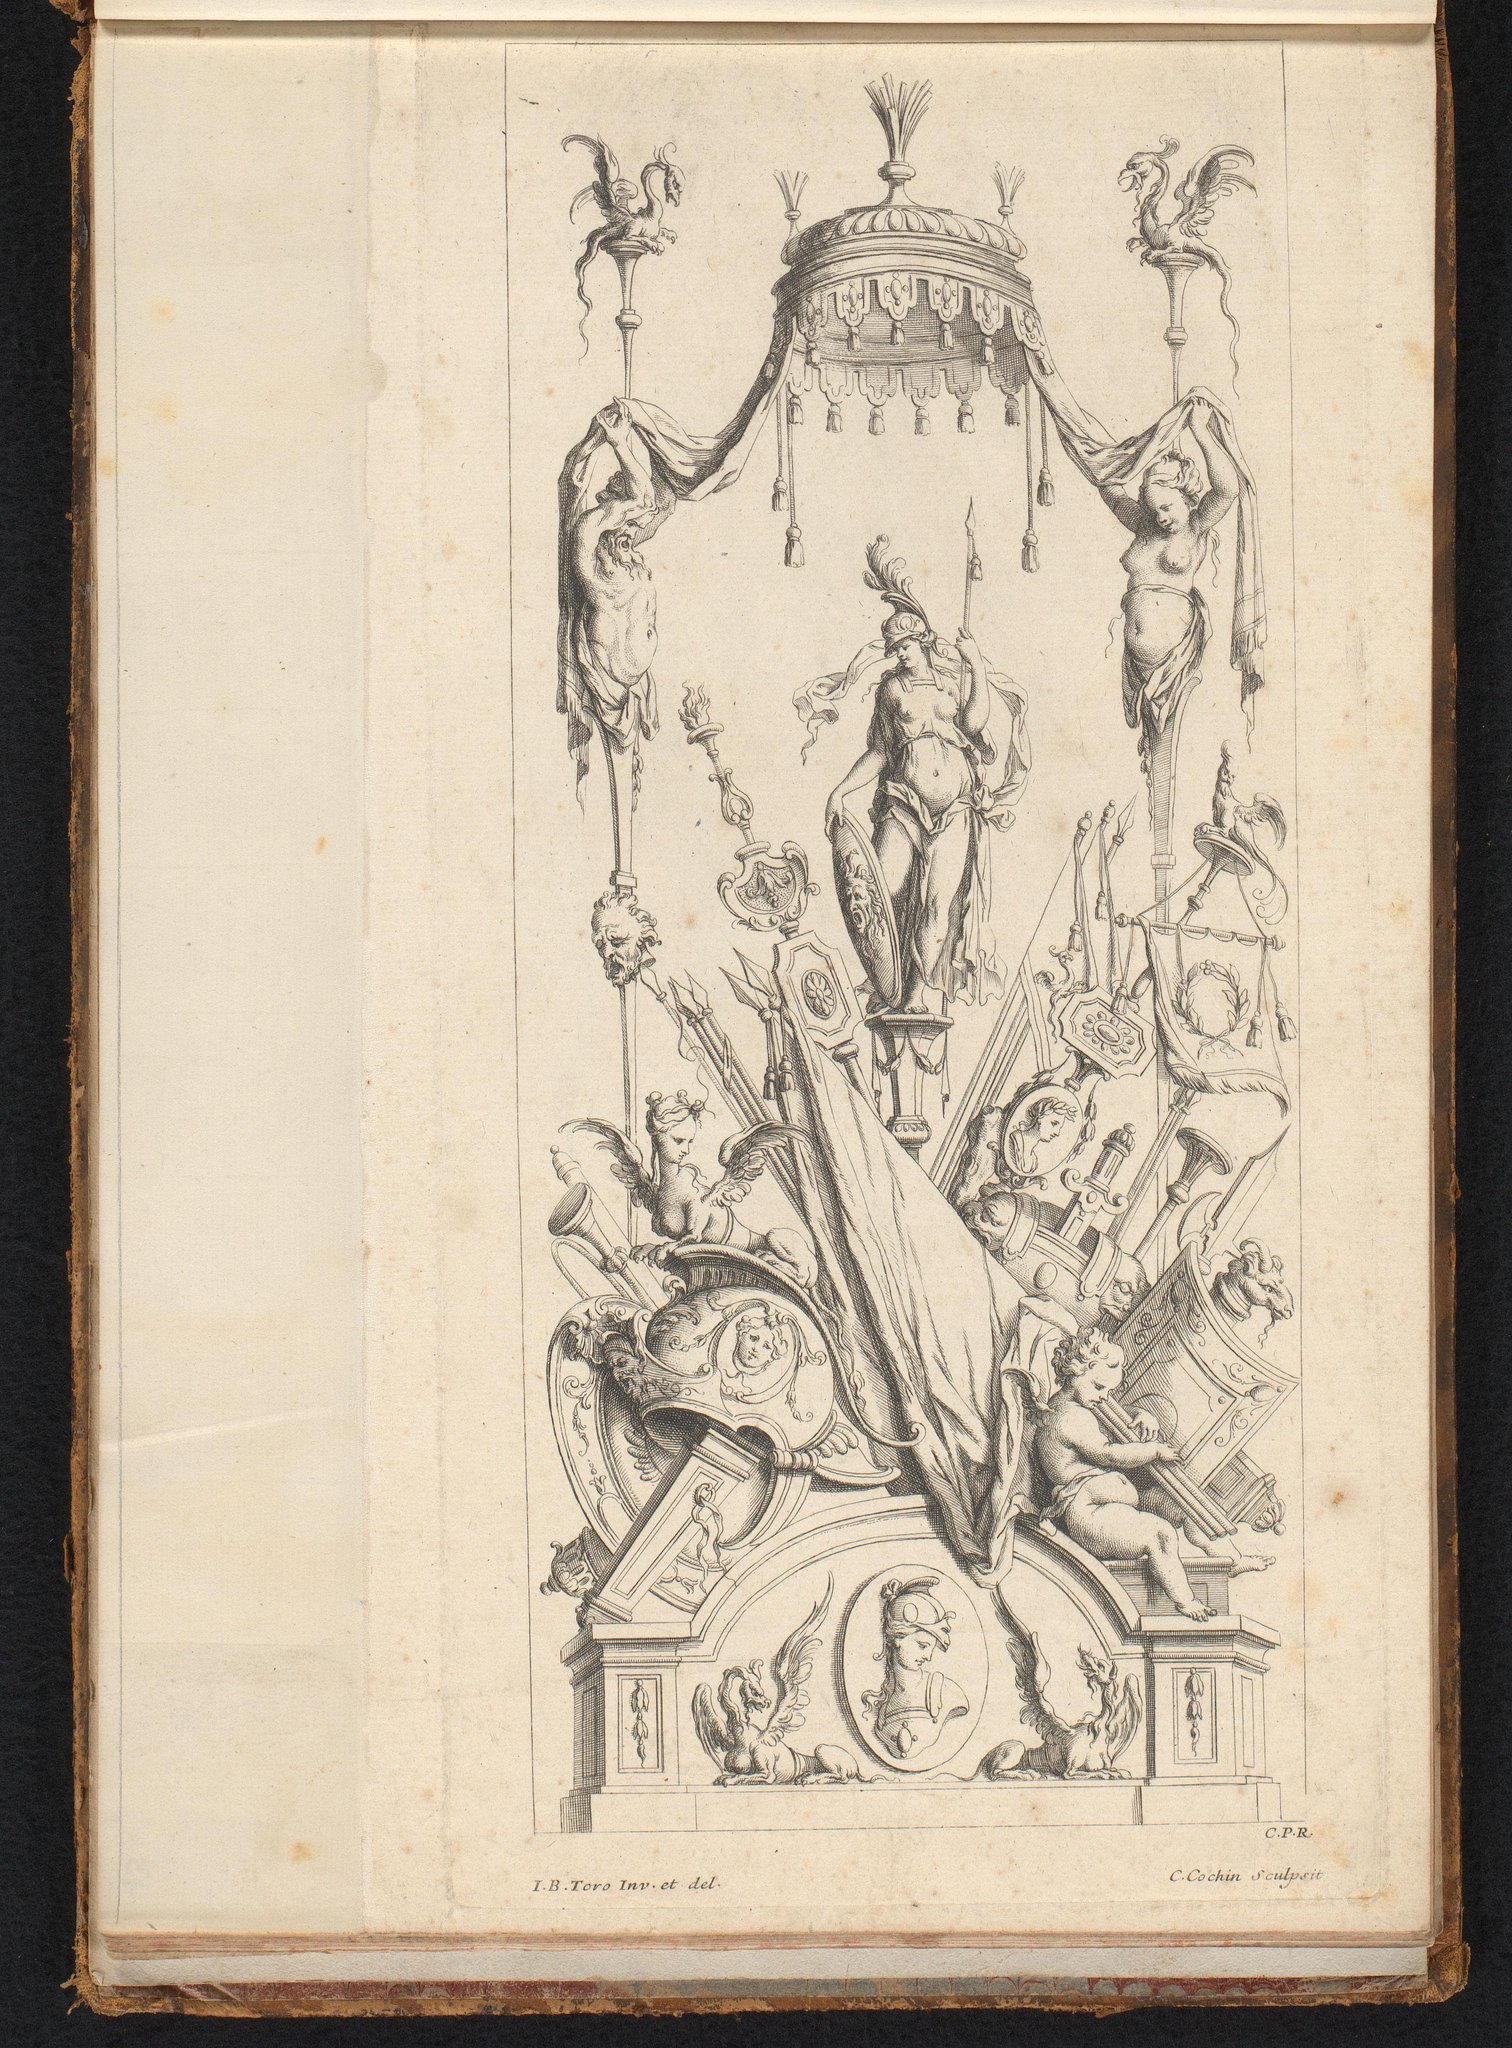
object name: ornament print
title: Ontwerpen voor ornamenten met oorlogstrofeeën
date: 1716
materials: paper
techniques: etching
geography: france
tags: 'tropaion', i.e. decorative ornament ~ weapons, (story of) minerva (pallas, athena), weapons, (military) flags and standards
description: Prent maakt deel uit van een serie van zes prenten.